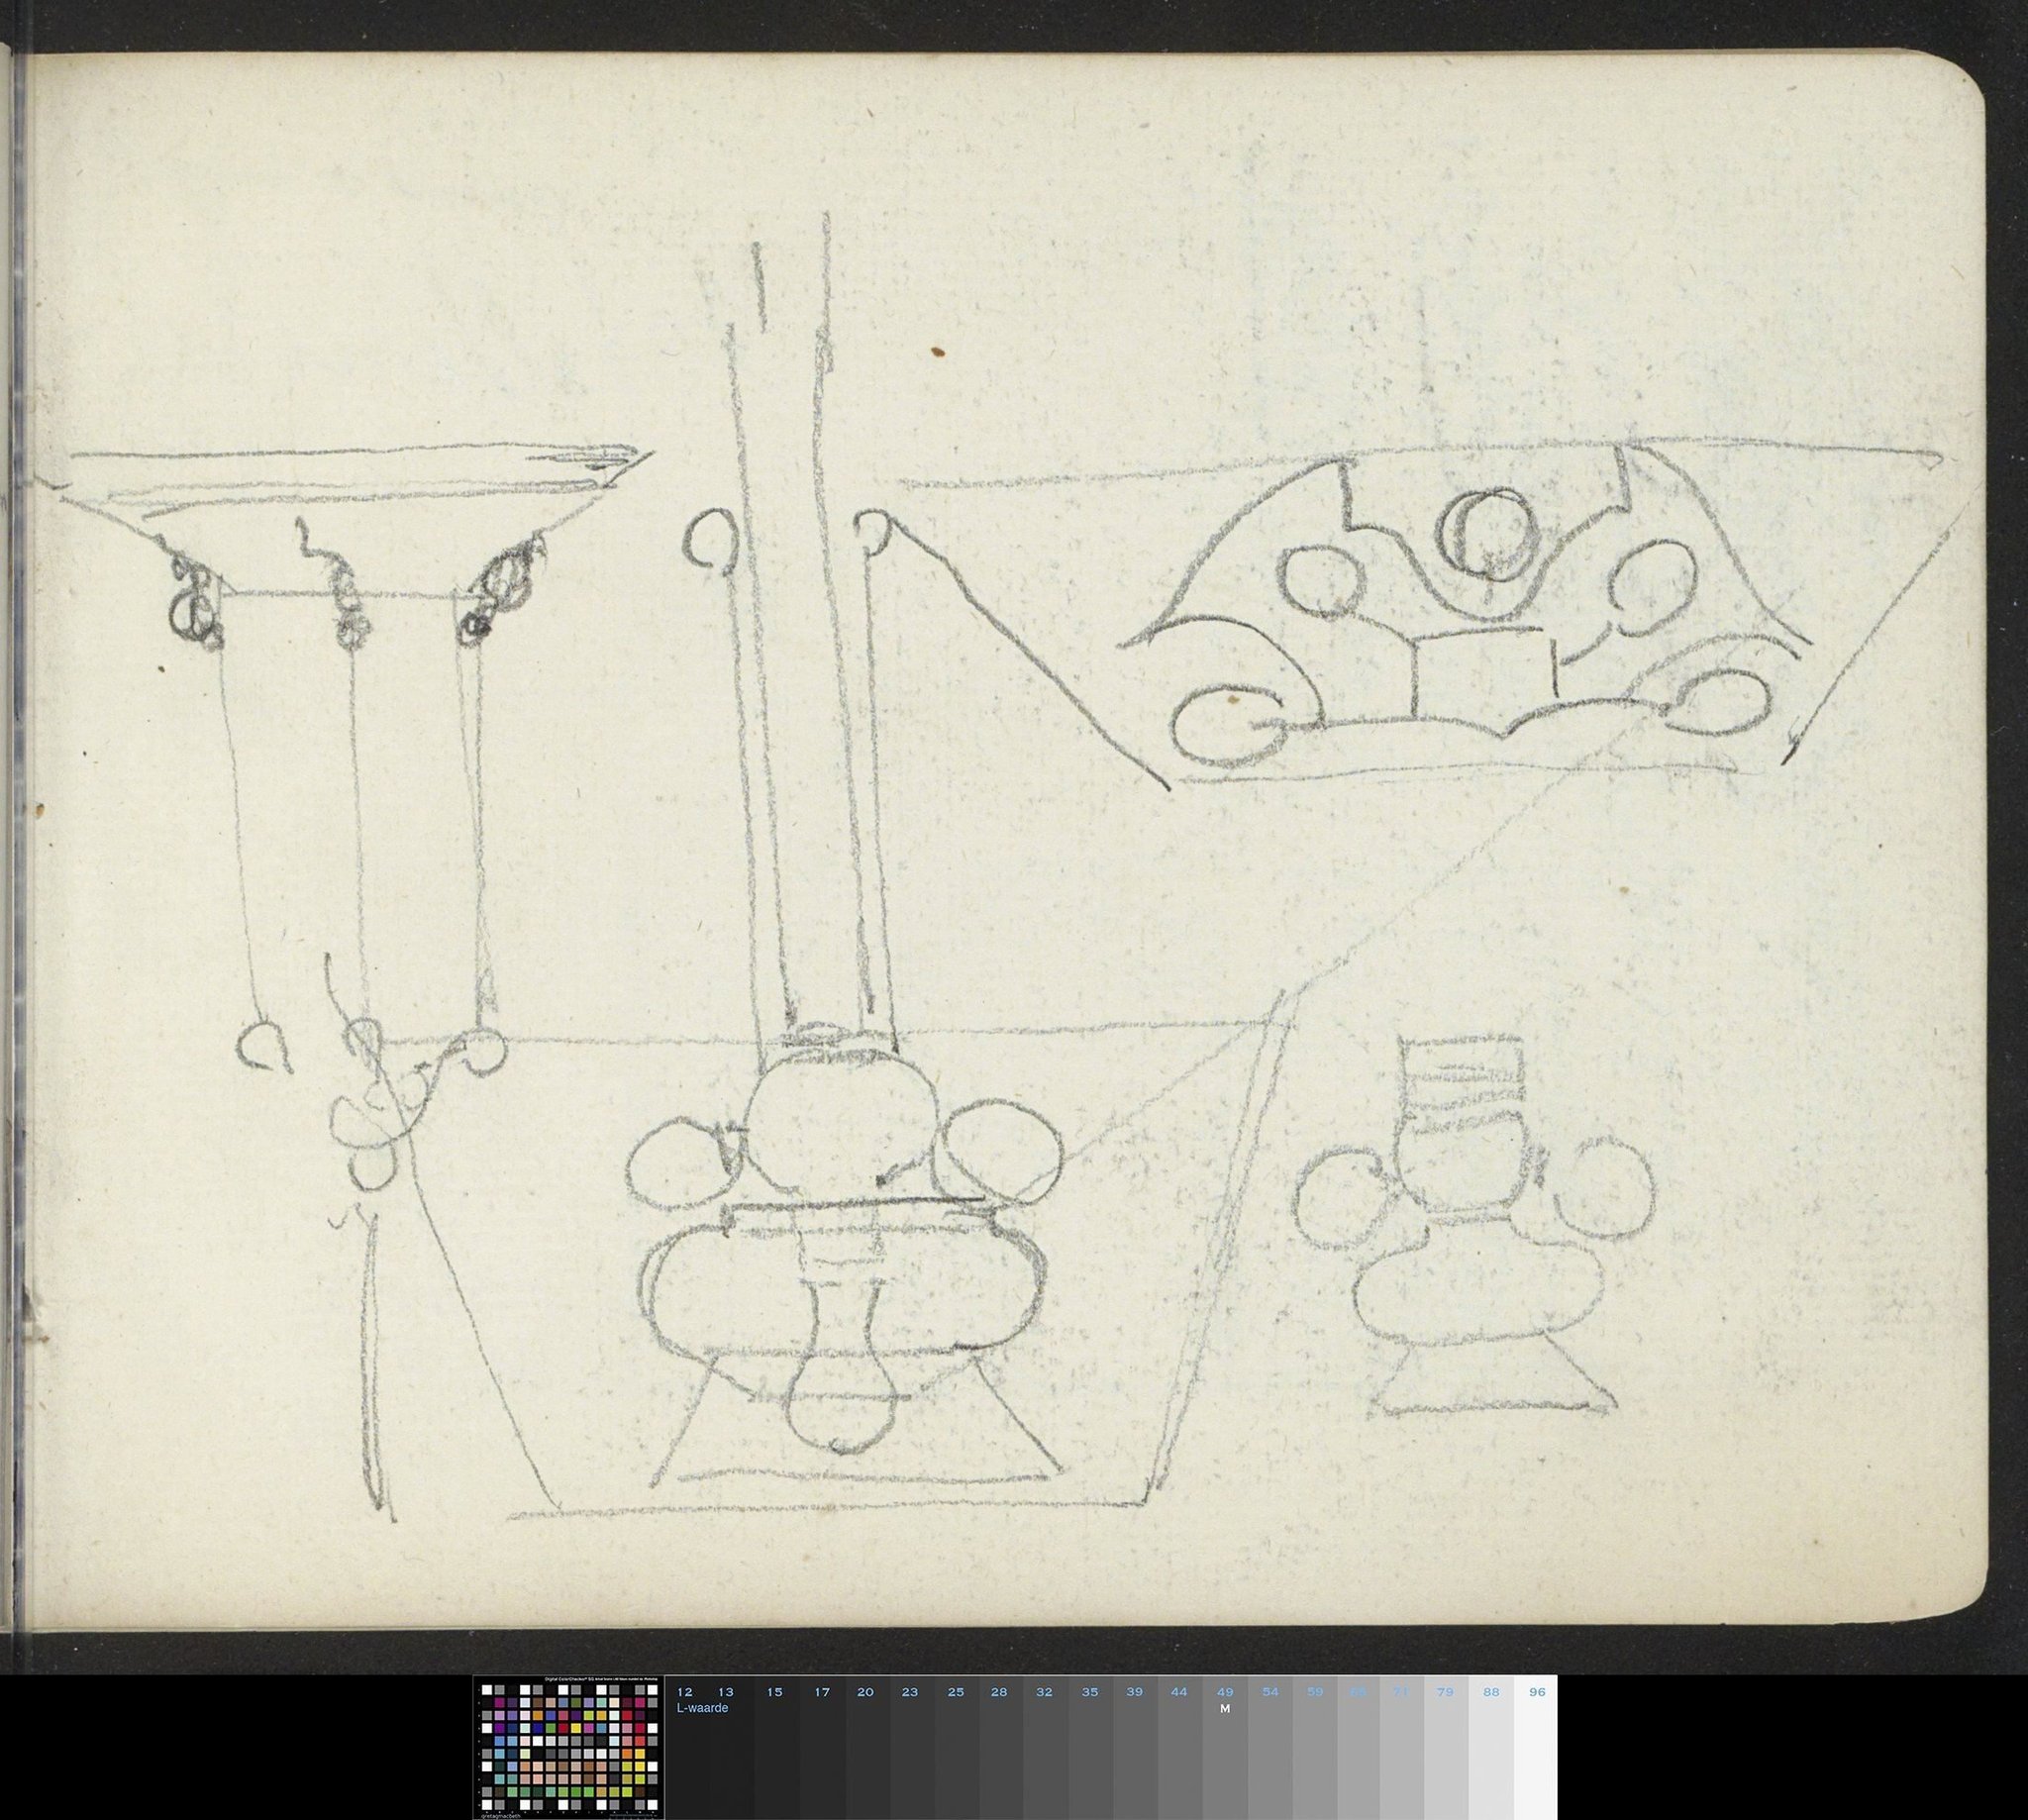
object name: sketchbook leaf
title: Ontwerpen voor een lampenkap en -voet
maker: carel adolph lion cachet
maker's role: draughtsman, print maker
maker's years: 1864-1945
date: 1928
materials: paper, pencil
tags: electric lamp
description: Blad 12 verso uit een schetsboek met 24 bladen.